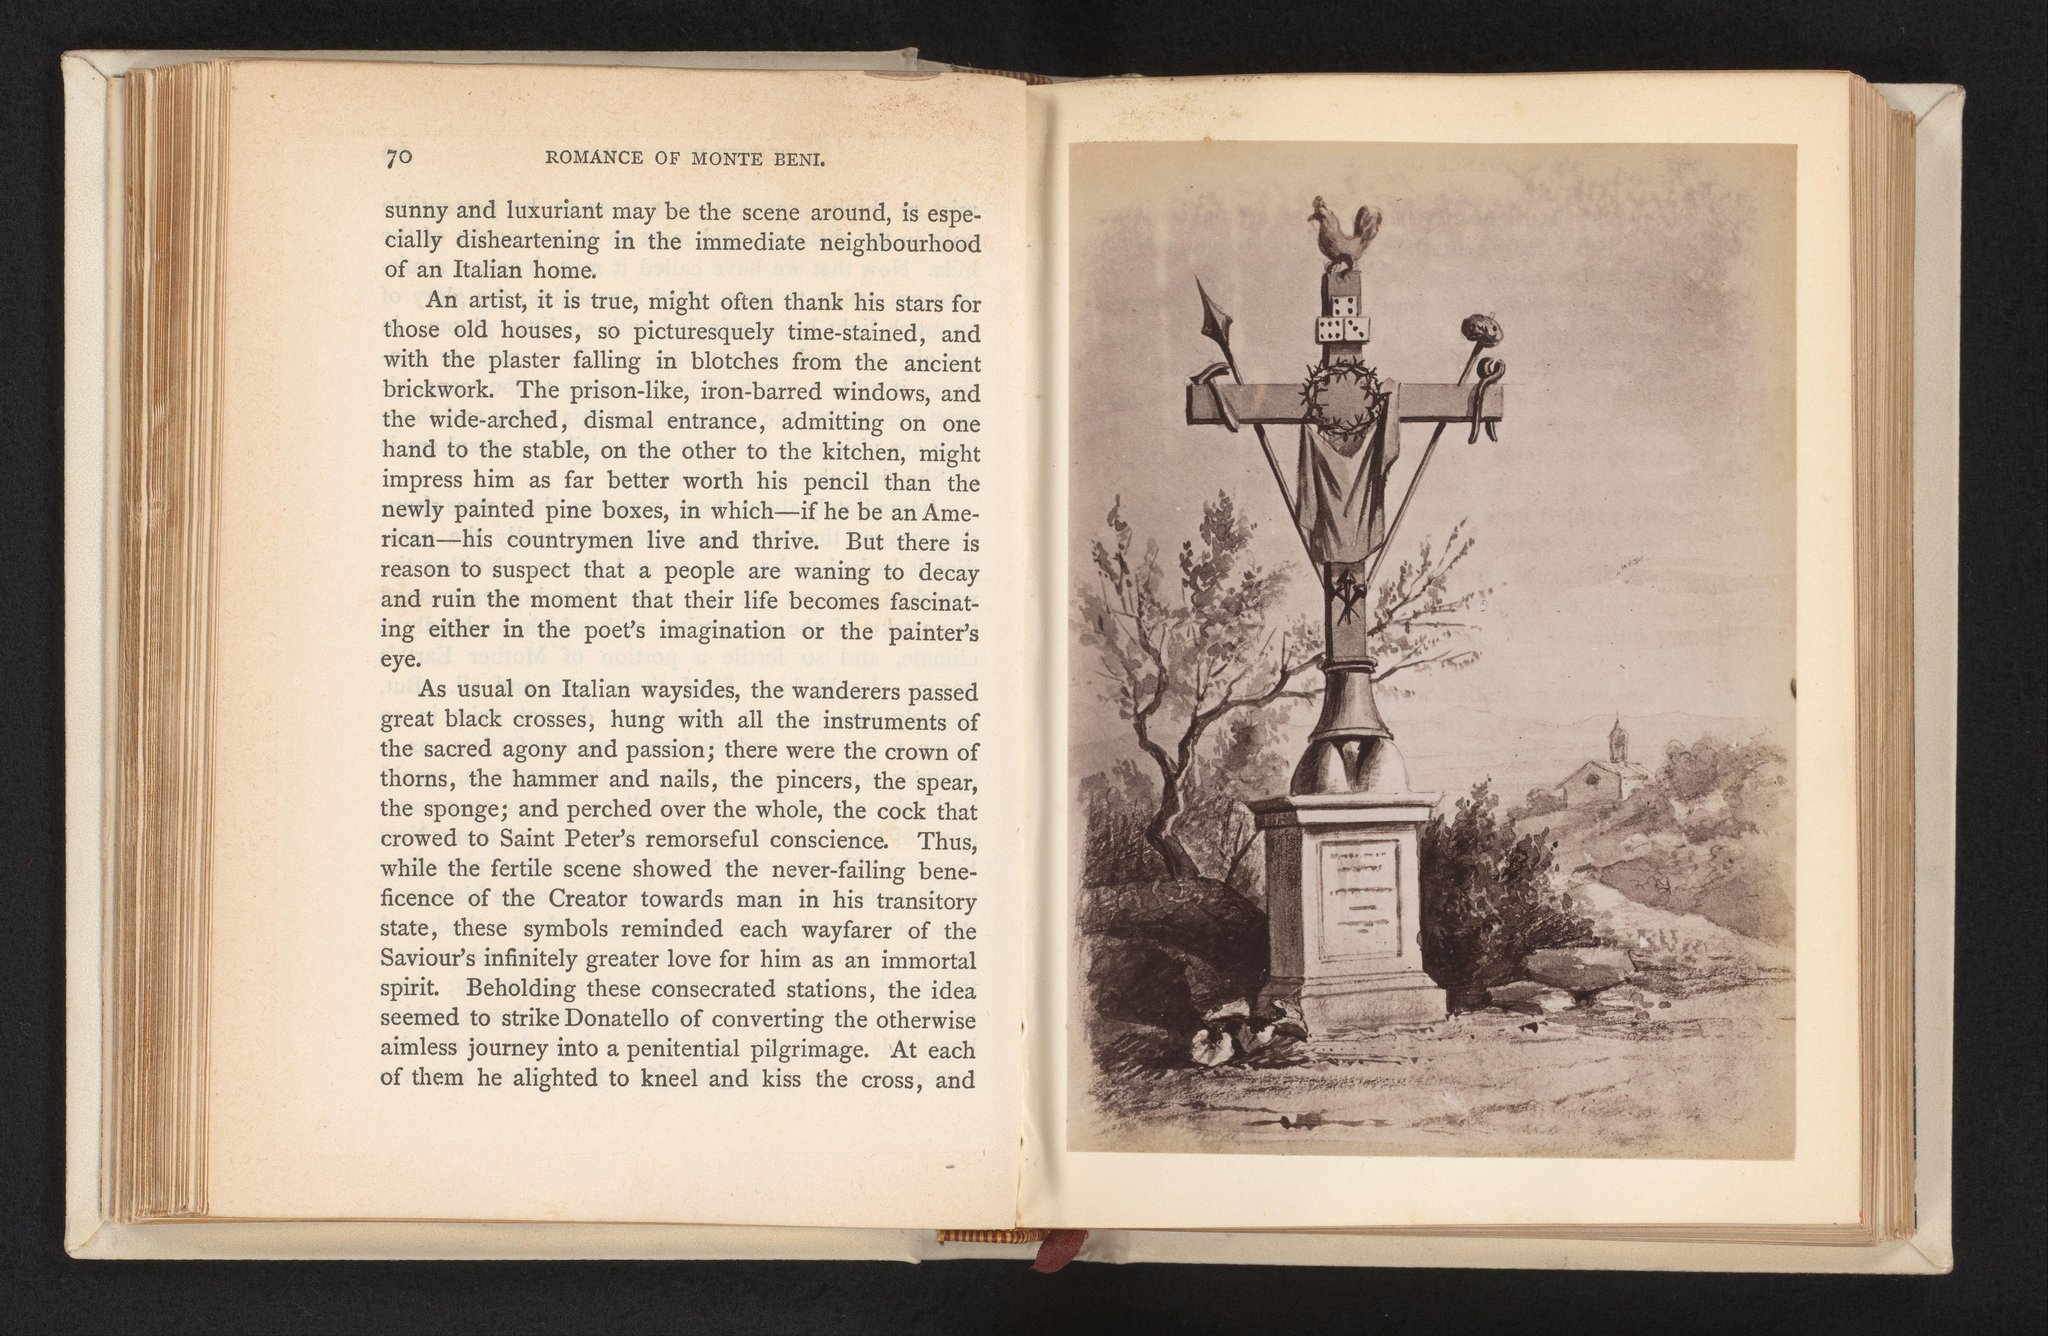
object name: photograph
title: Fotoreproductie van een tekening van een kruis met verwijzingen naar de lijdensweg van Christus in de buitenlucht, vermoedelijk in Italië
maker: Anonymous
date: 1850-1860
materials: photographic support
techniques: albumen print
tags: the cross ~ symbols of christ